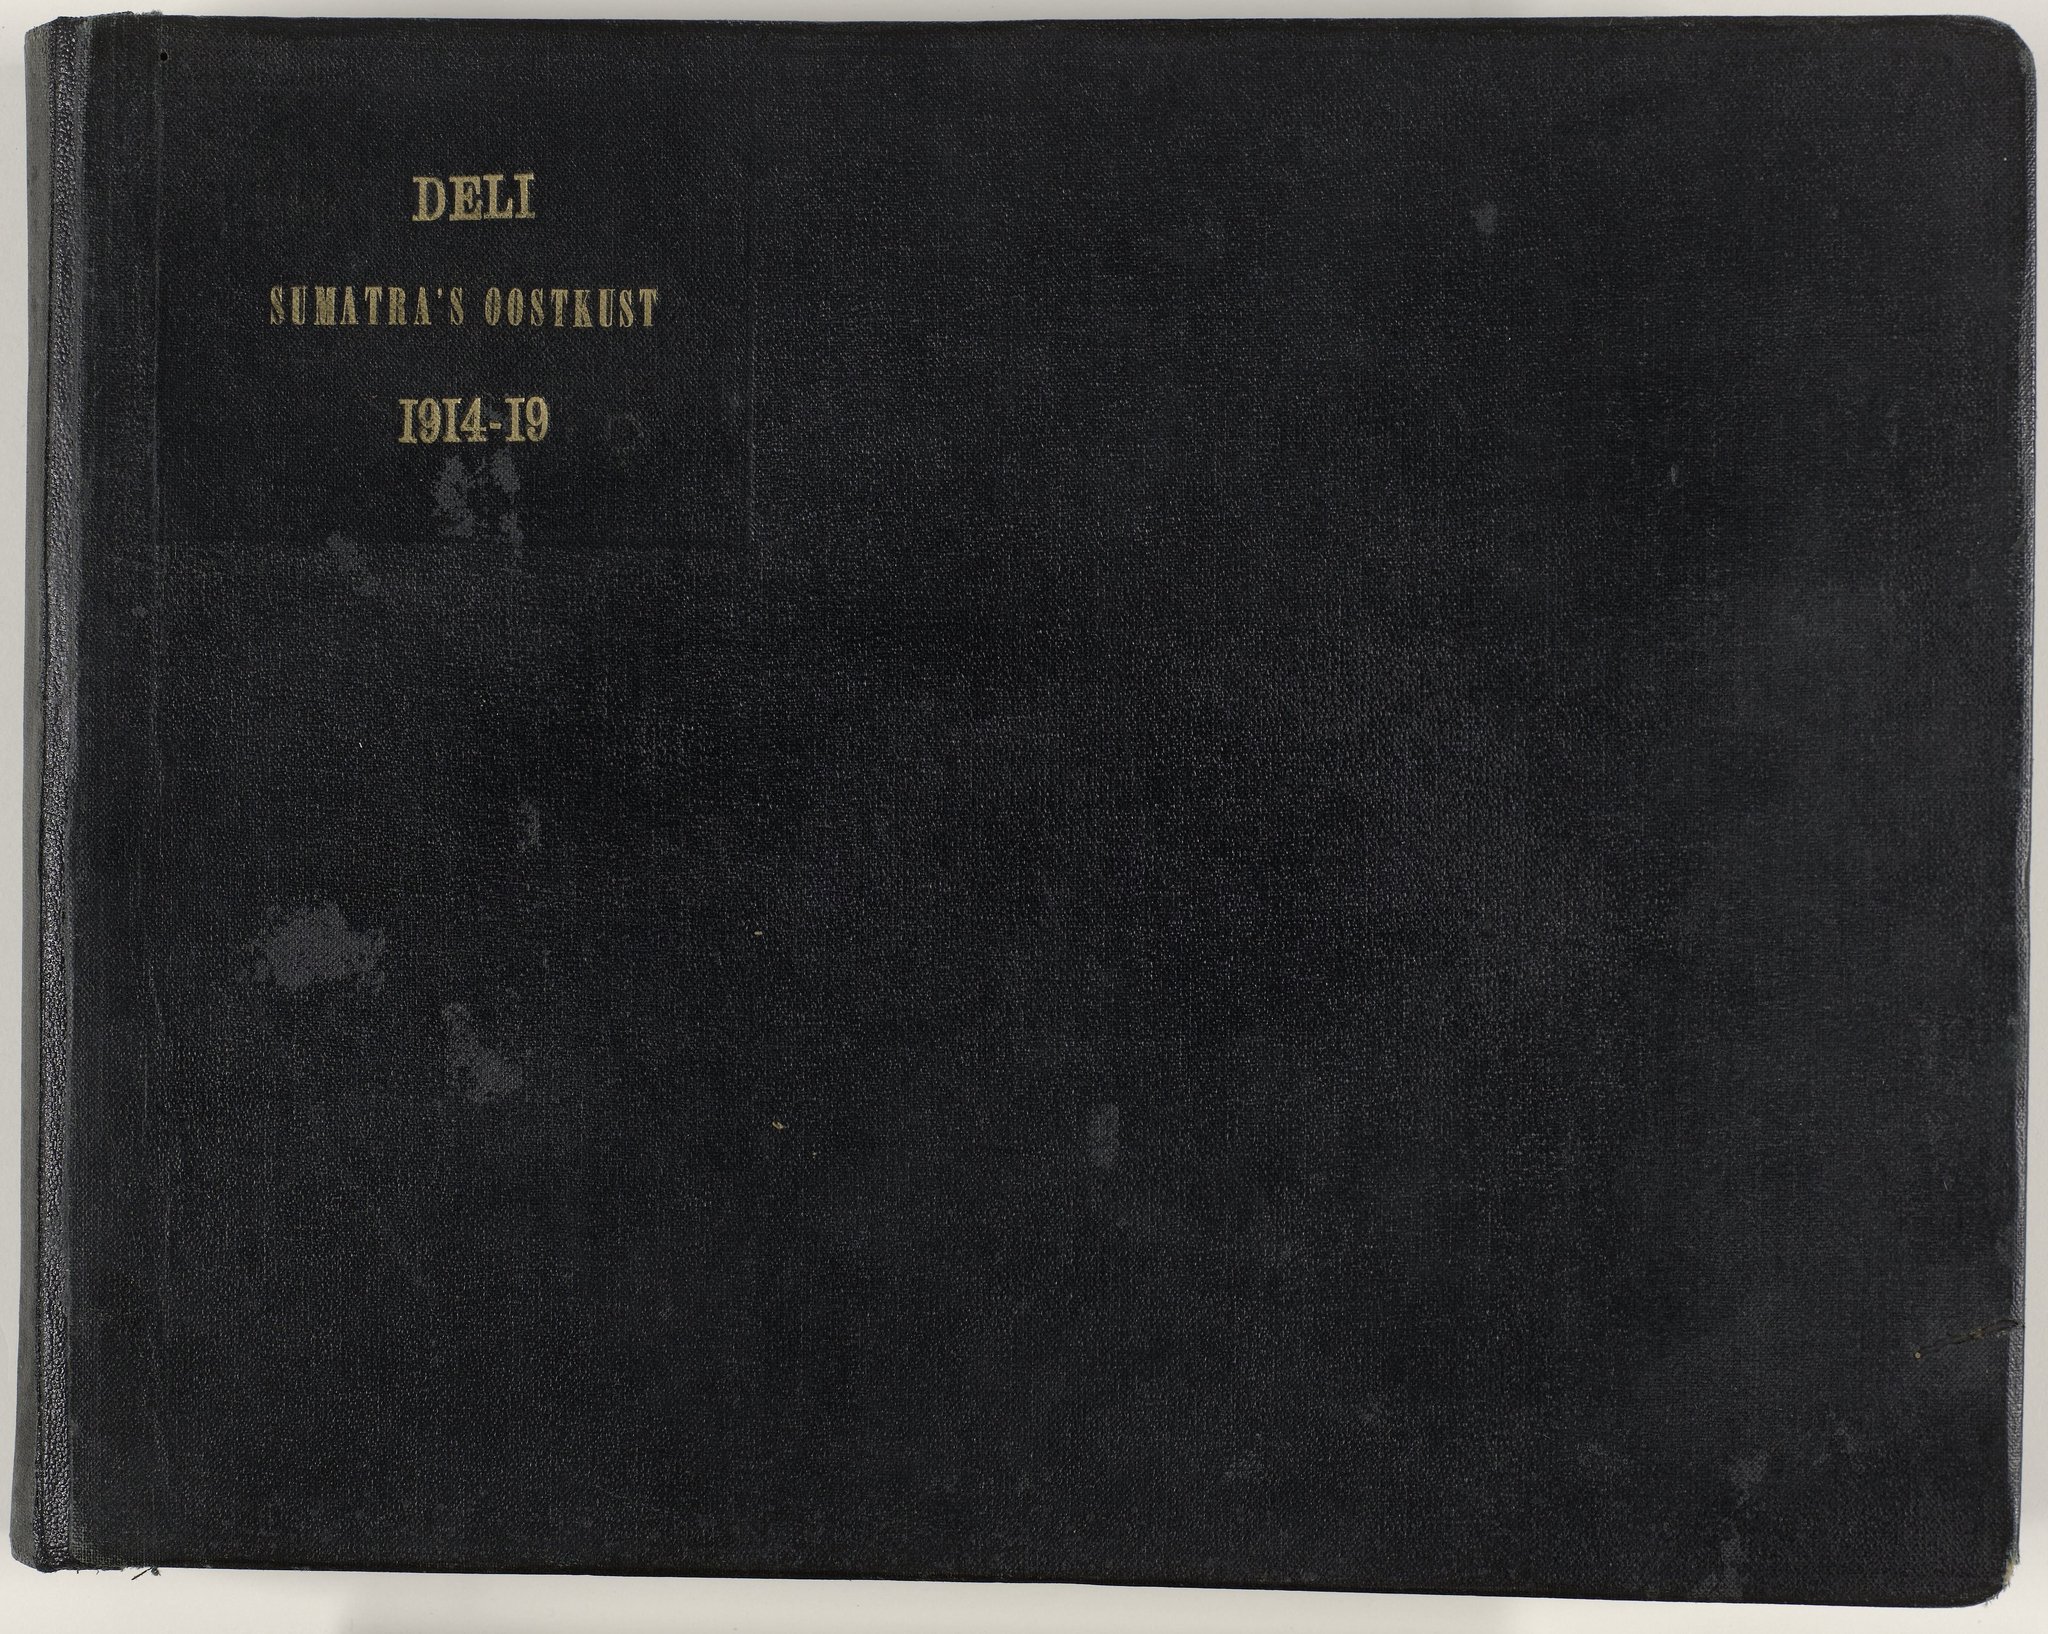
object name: photograph album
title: Fotoalbum van Bennink en Riphagen, architecten en aannemers te Medan 1914-1919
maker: Anonymous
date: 1914-1919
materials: cardboard, linen, paper, photographic support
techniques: gelatin silver print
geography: medan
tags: architecture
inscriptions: inscription: ‘DELI SUMATRA'S OOSTKUST 1914-19’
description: Zwart oblong fotoalbum met 91 foto's van projecten uitgevoerd door het Nederlandse architectenbureau en aannemersbedrijf Bennink en Riphagen in de jaren ca. 1914-1919, gevestigd in Medan te Deli op Oost-Sumatra. Album met 39 bladen van bruin papier met op beide bladzijden één of meerdere foto's geplakt. Band bekleed met zwart linnen met op voorzijde in goud gestempeld opschrift: Deli Sumatra's Oostkust 1914-19.